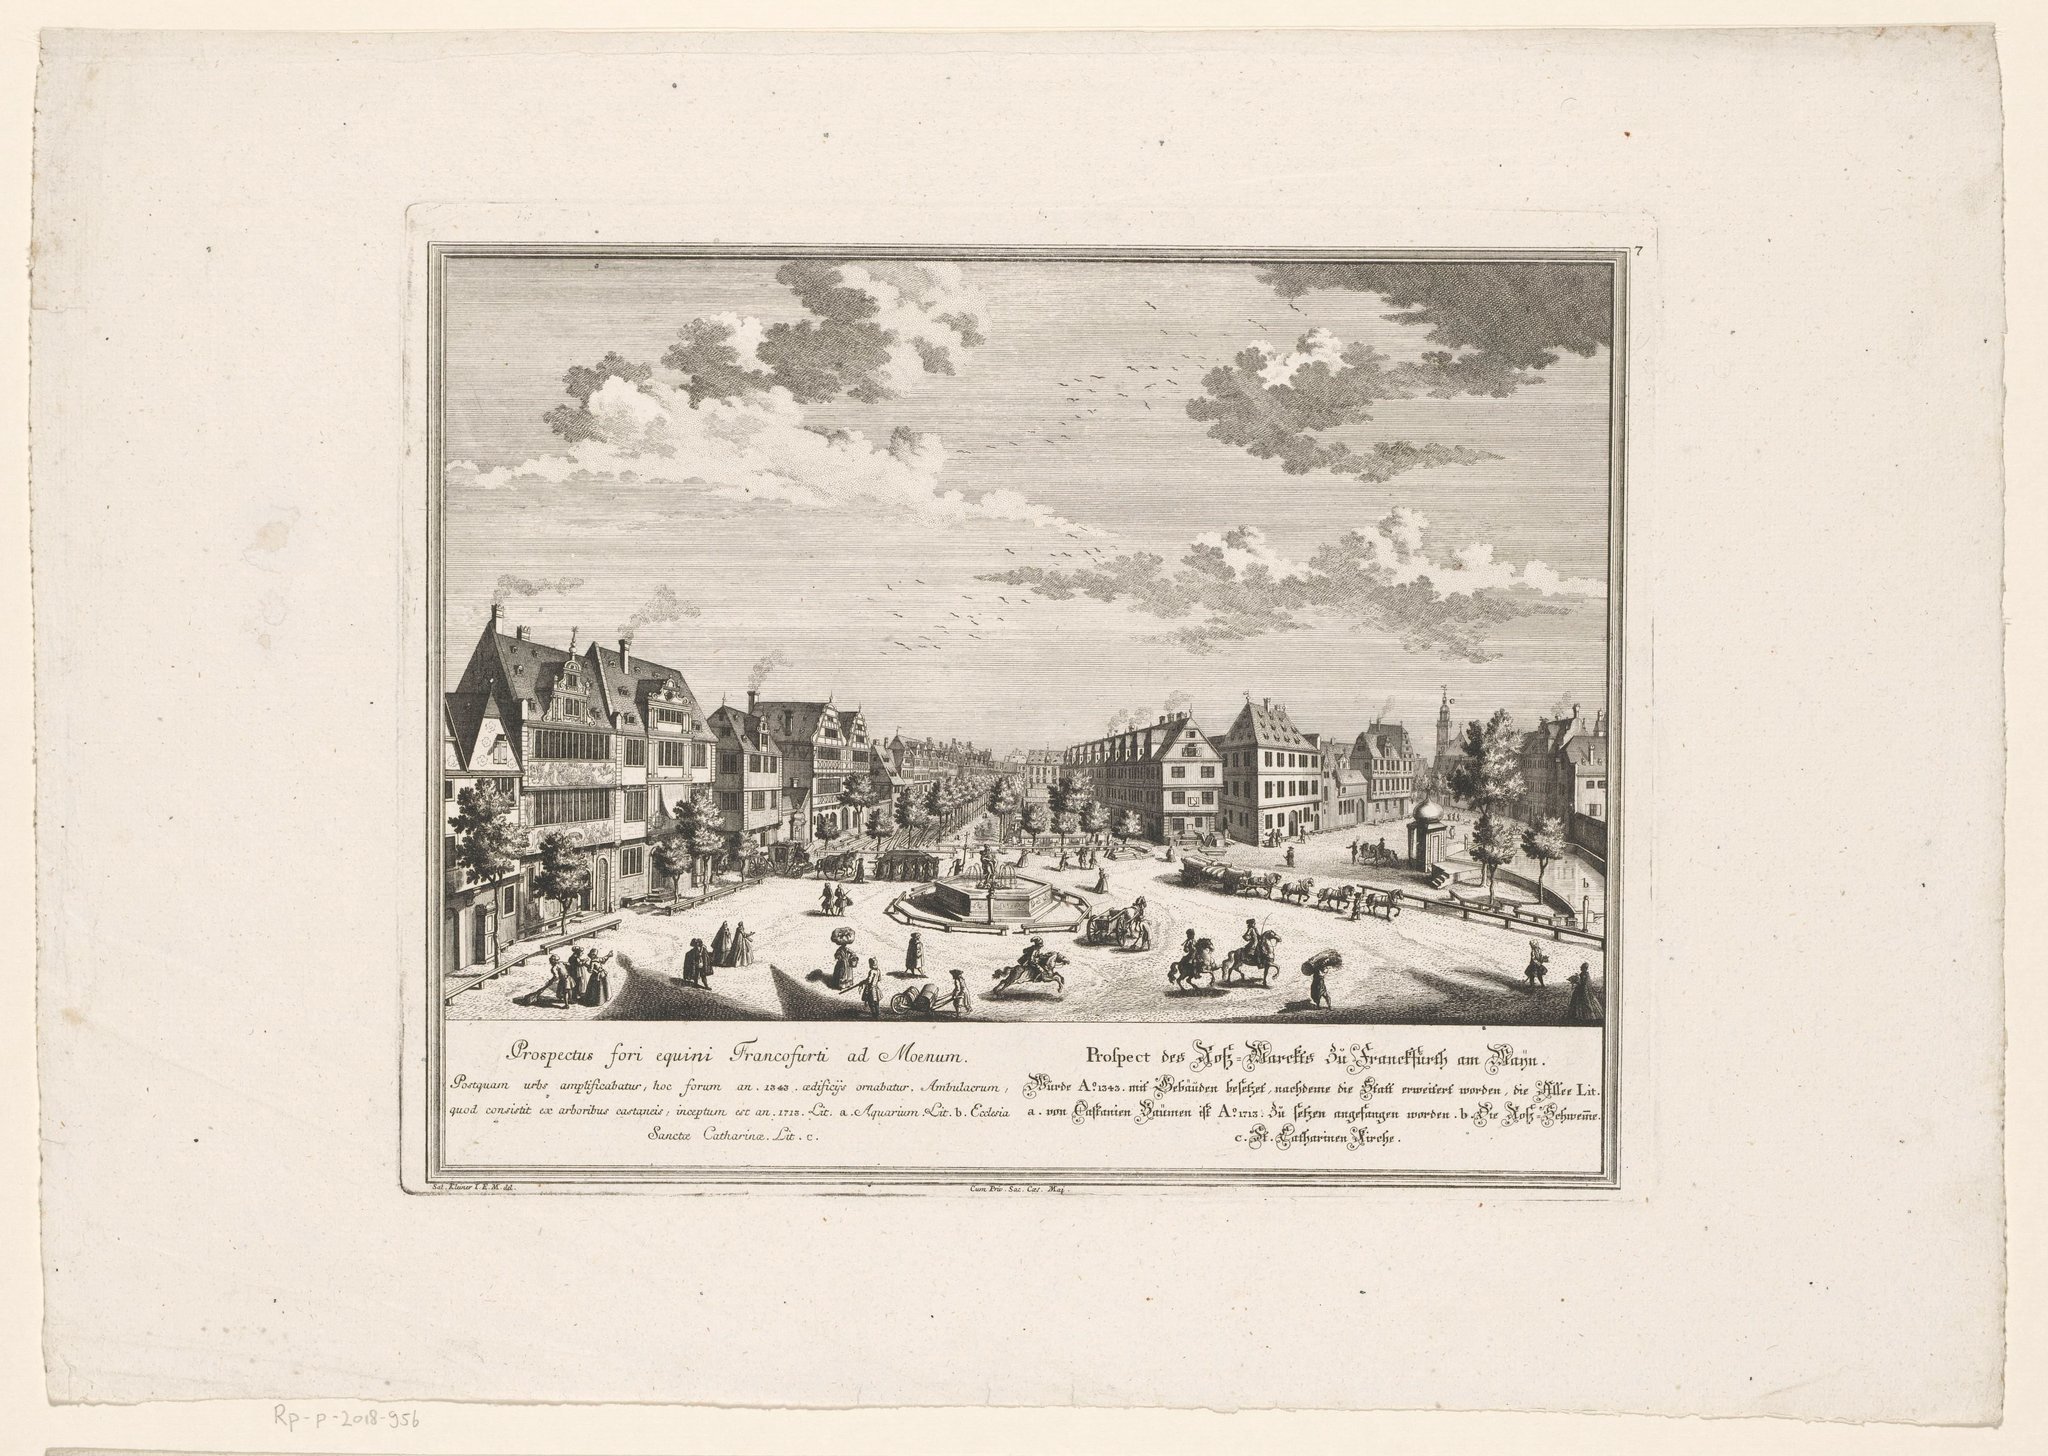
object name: print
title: Prospectus fori equini Francofurti ad Moenum (...) / Prospect des Hofs-Marckts zü Frankfurth am Maïn (...)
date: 1738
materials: paper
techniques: engraving, etching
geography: augsburg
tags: square, place, circus, etc., city-view in general; 'veduta' - ii - ideal city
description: Prent gebruikt in: Francofurtum ad Moenum Floridum (...). Augsburg: Johann Andreas Pfeffel, 1738.